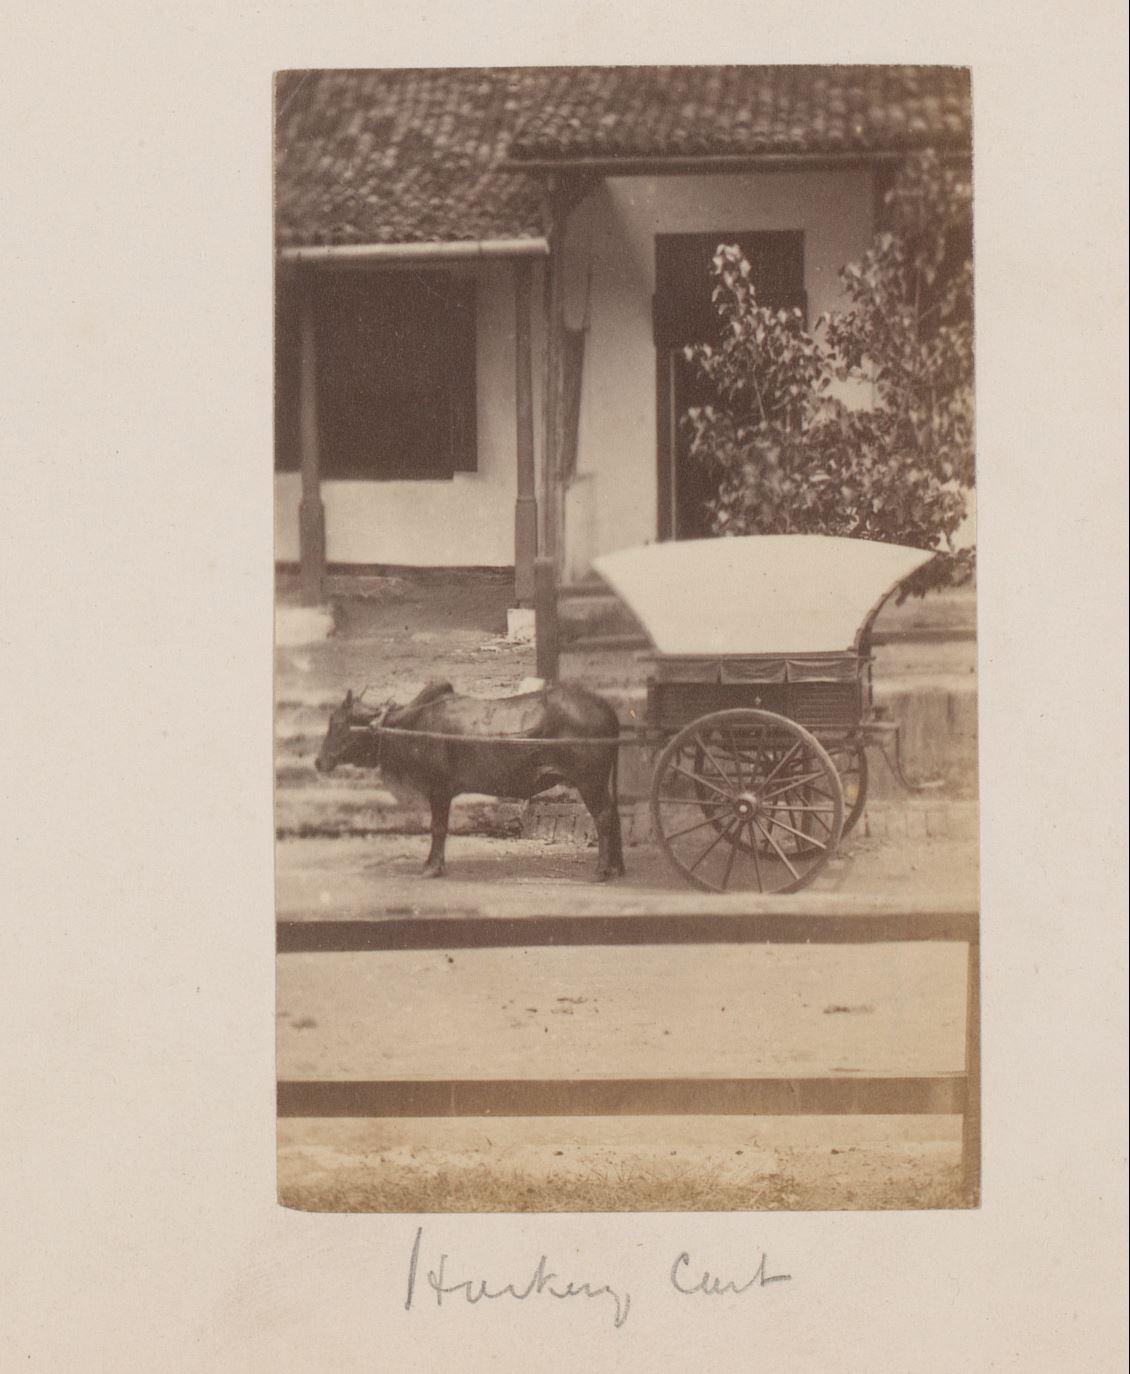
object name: photograph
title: Wagon with an ox, a house on the background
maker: Anonymous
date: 1880-1900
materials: cardboard, paper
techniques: albumen print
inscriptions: number: ‘1596’, caption: ‘Hunting Cart’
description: Wagen met os, een huis op de achtergrond. Object zit samen met de andere foto's met nummer RP-F-00-6678 op één blad geplakt.